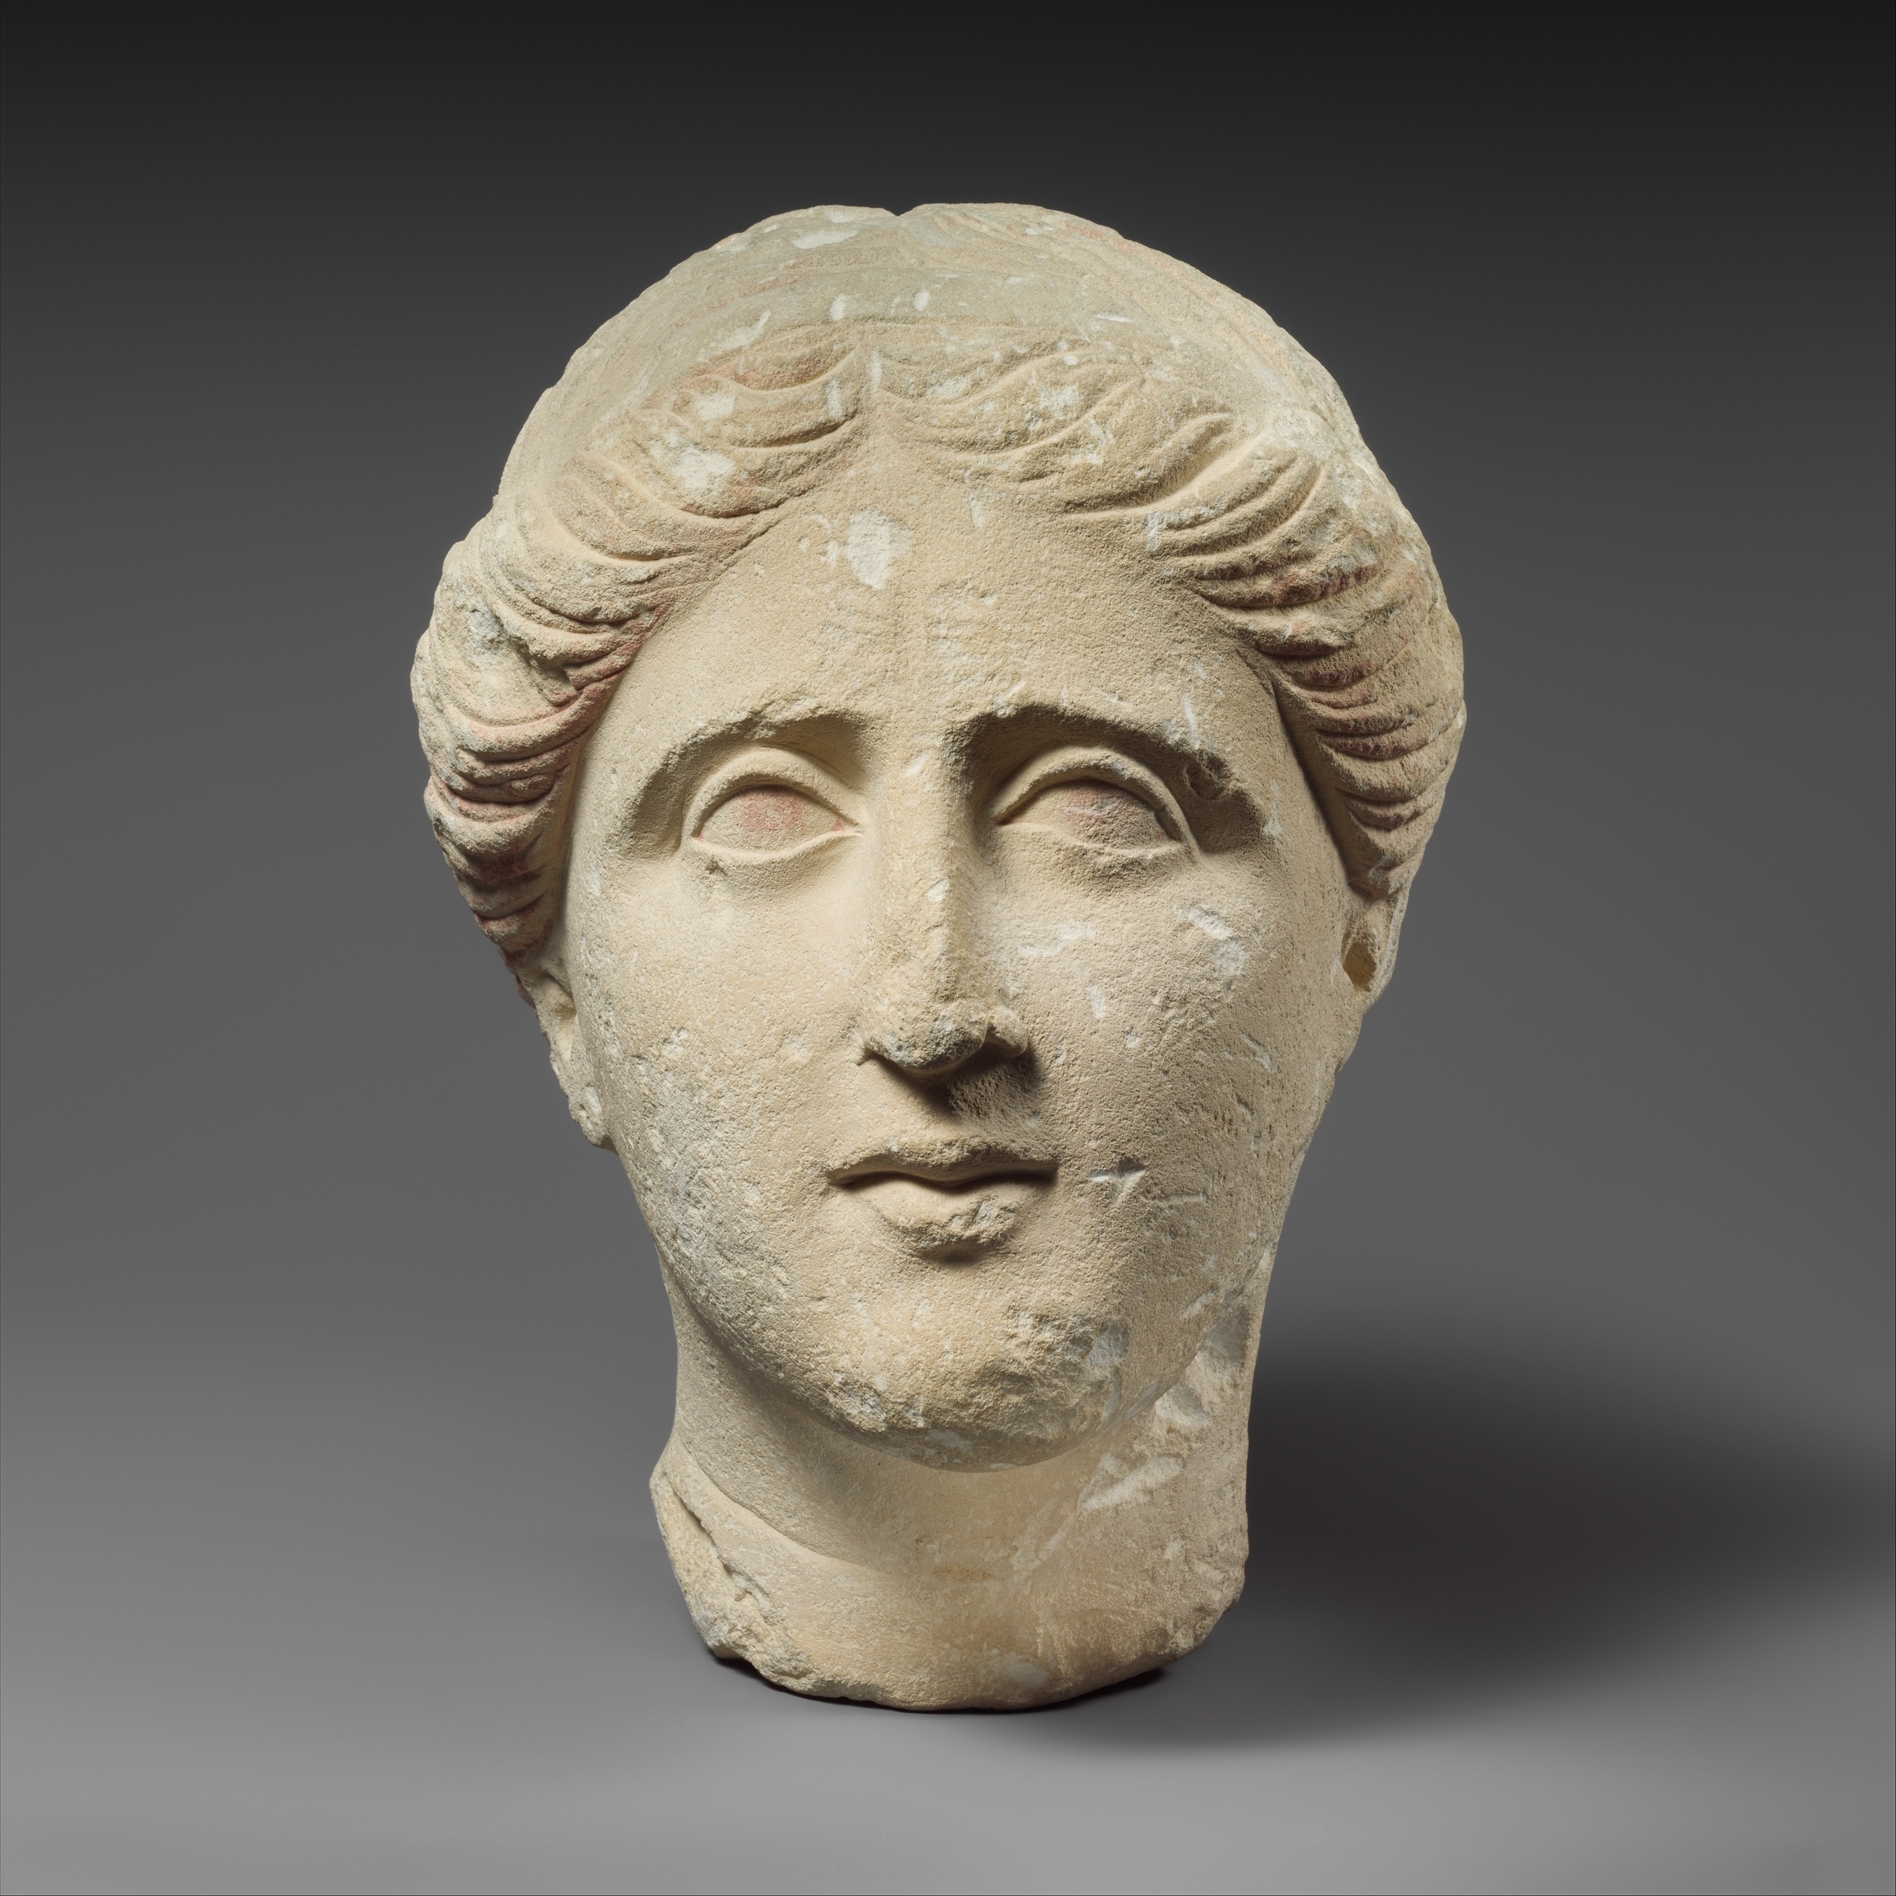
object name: head of a woman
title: Limestone head of a female votary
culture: cypriot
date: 34-1 BCE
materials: limestone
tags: heads,women